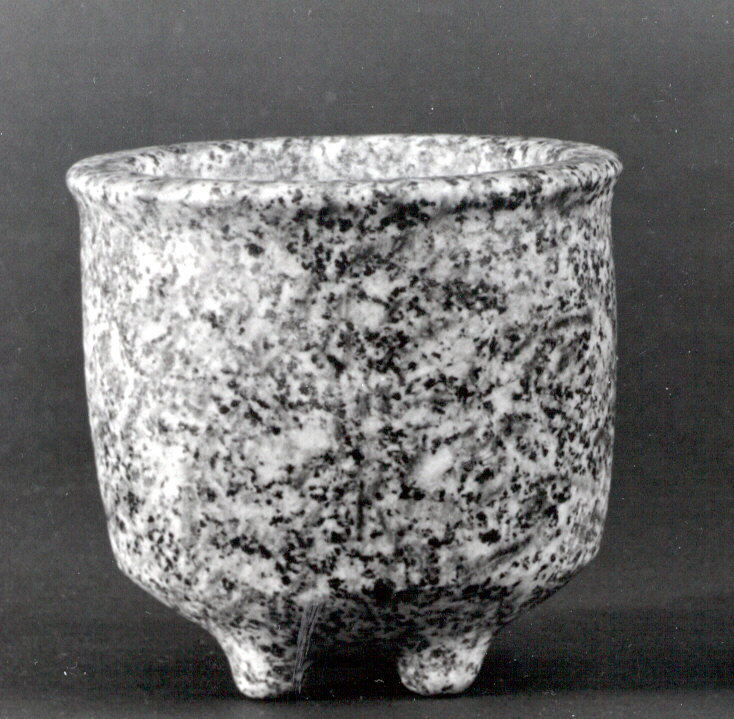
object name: bowl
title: Footed bowl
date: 7333-7001 BCE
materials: granite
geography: syria